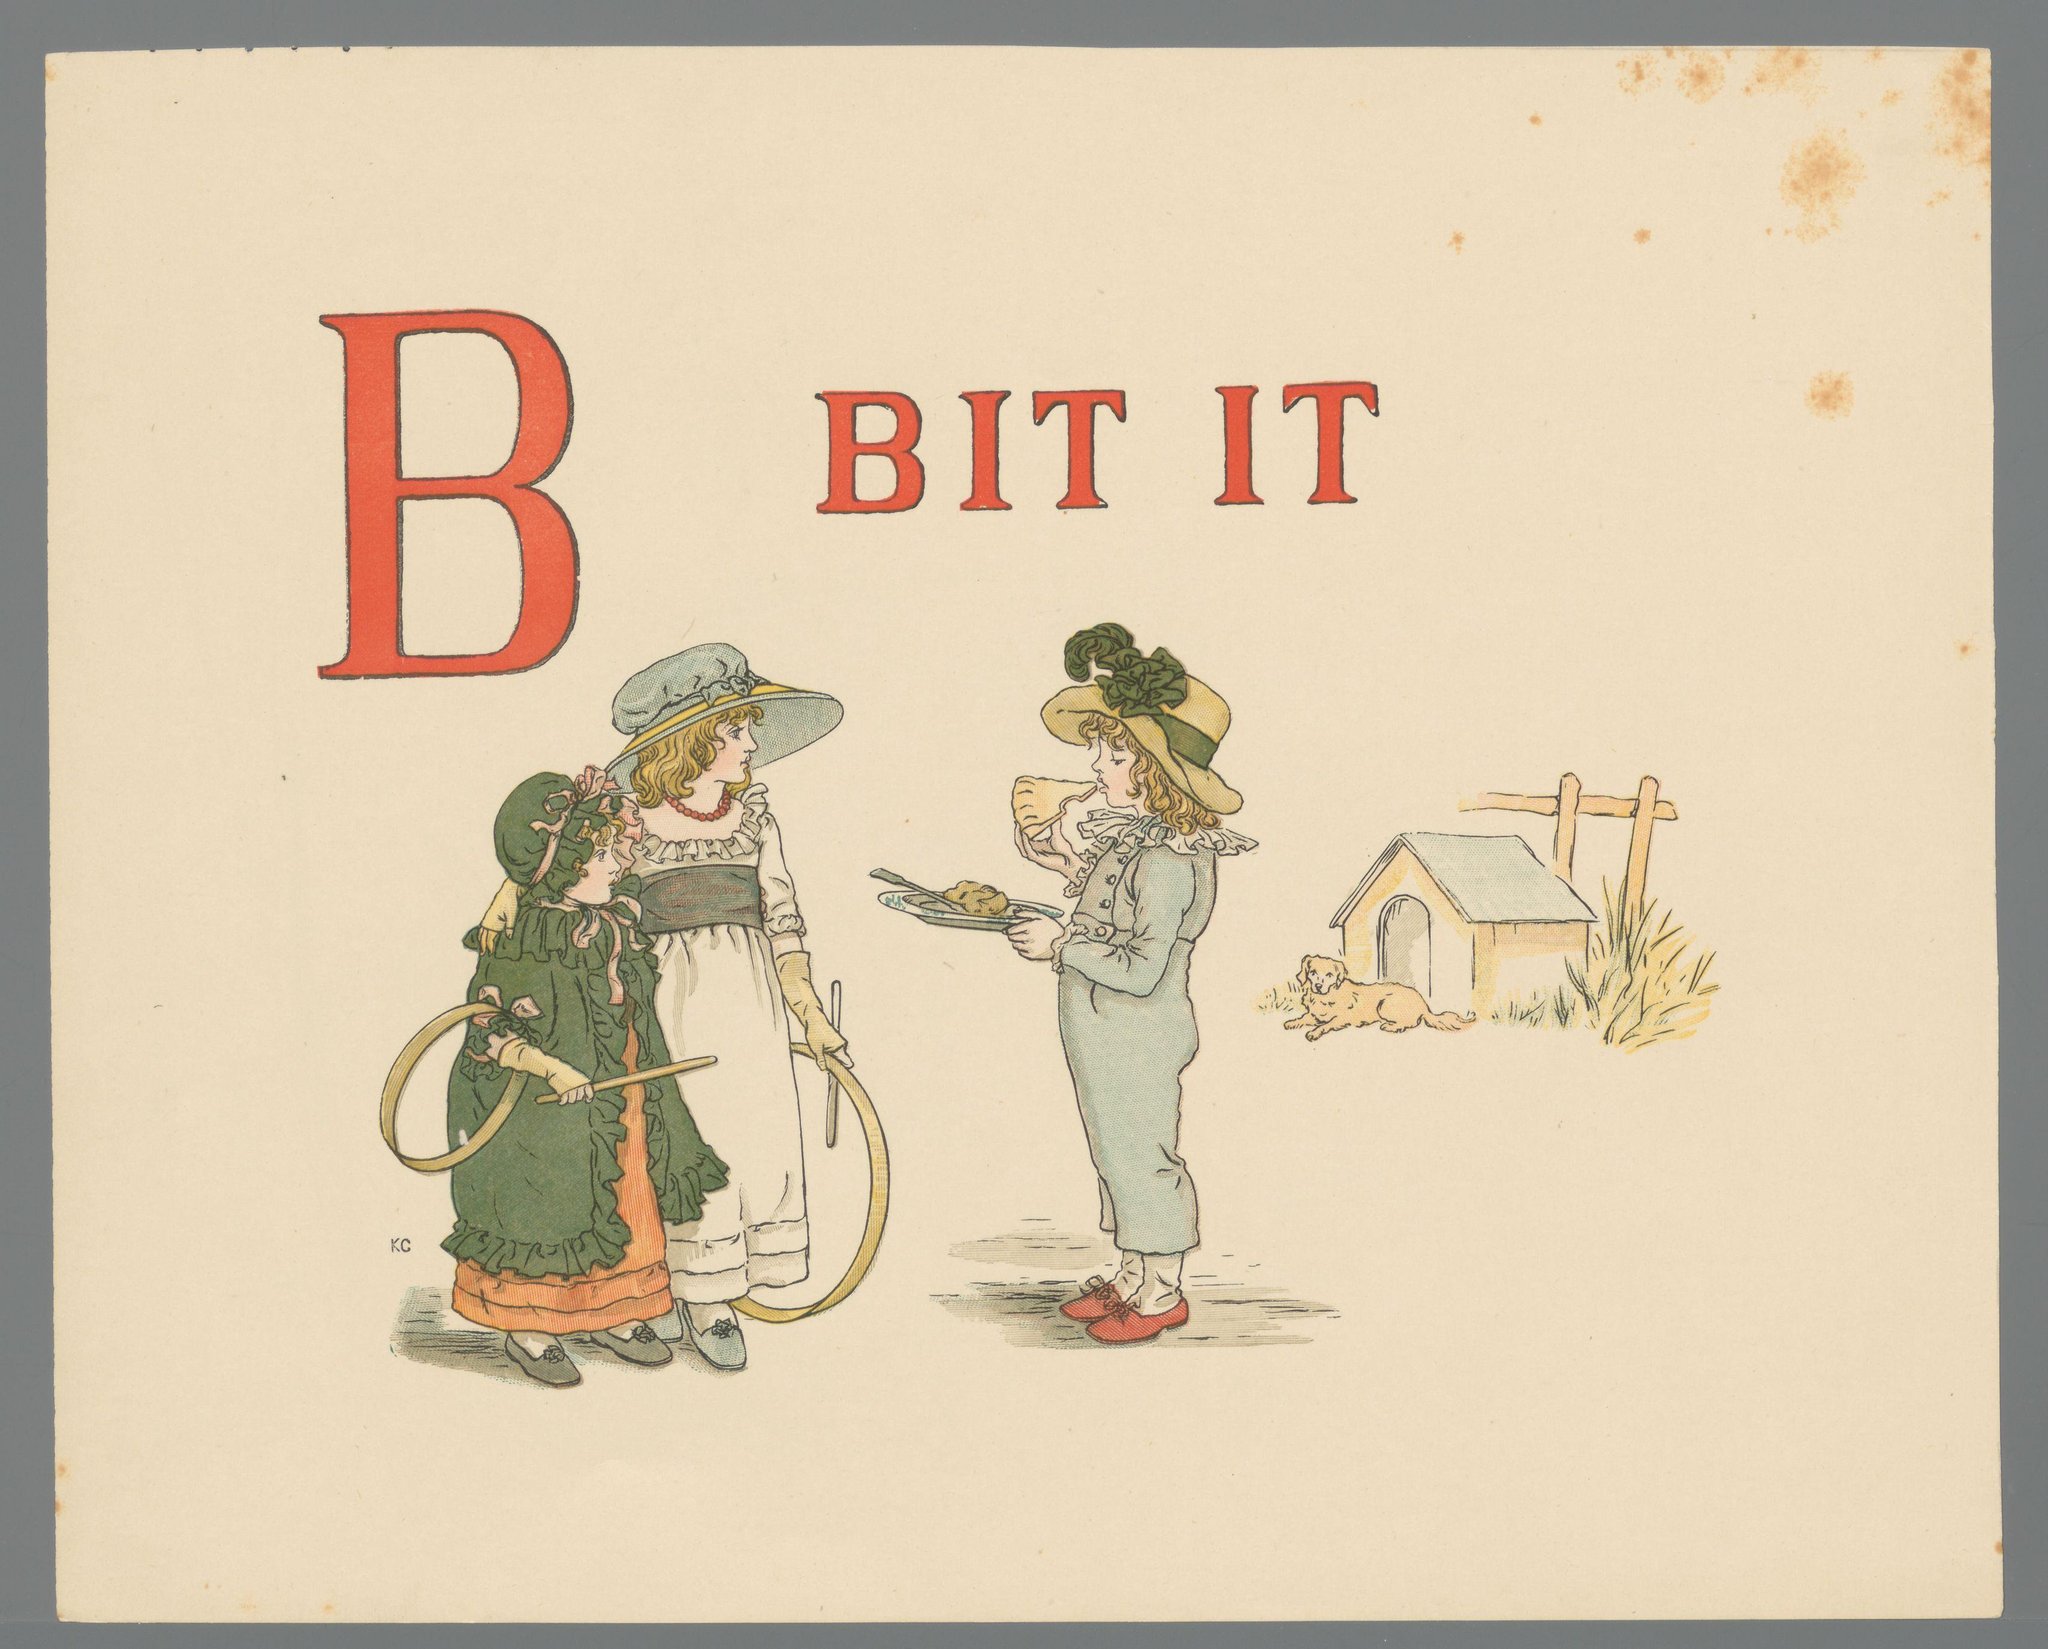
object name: book illustration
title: B Bit it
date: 1886-1927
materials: paper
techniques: wood engraving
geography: london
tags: pie, child (+ three persons), games using special objects (marbles, top, hoop, etc.)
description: Prent uit: Greenaway, Kate. A apple pie. Londen: George Routledge & Sons, 1886. Of een latere uitgave.